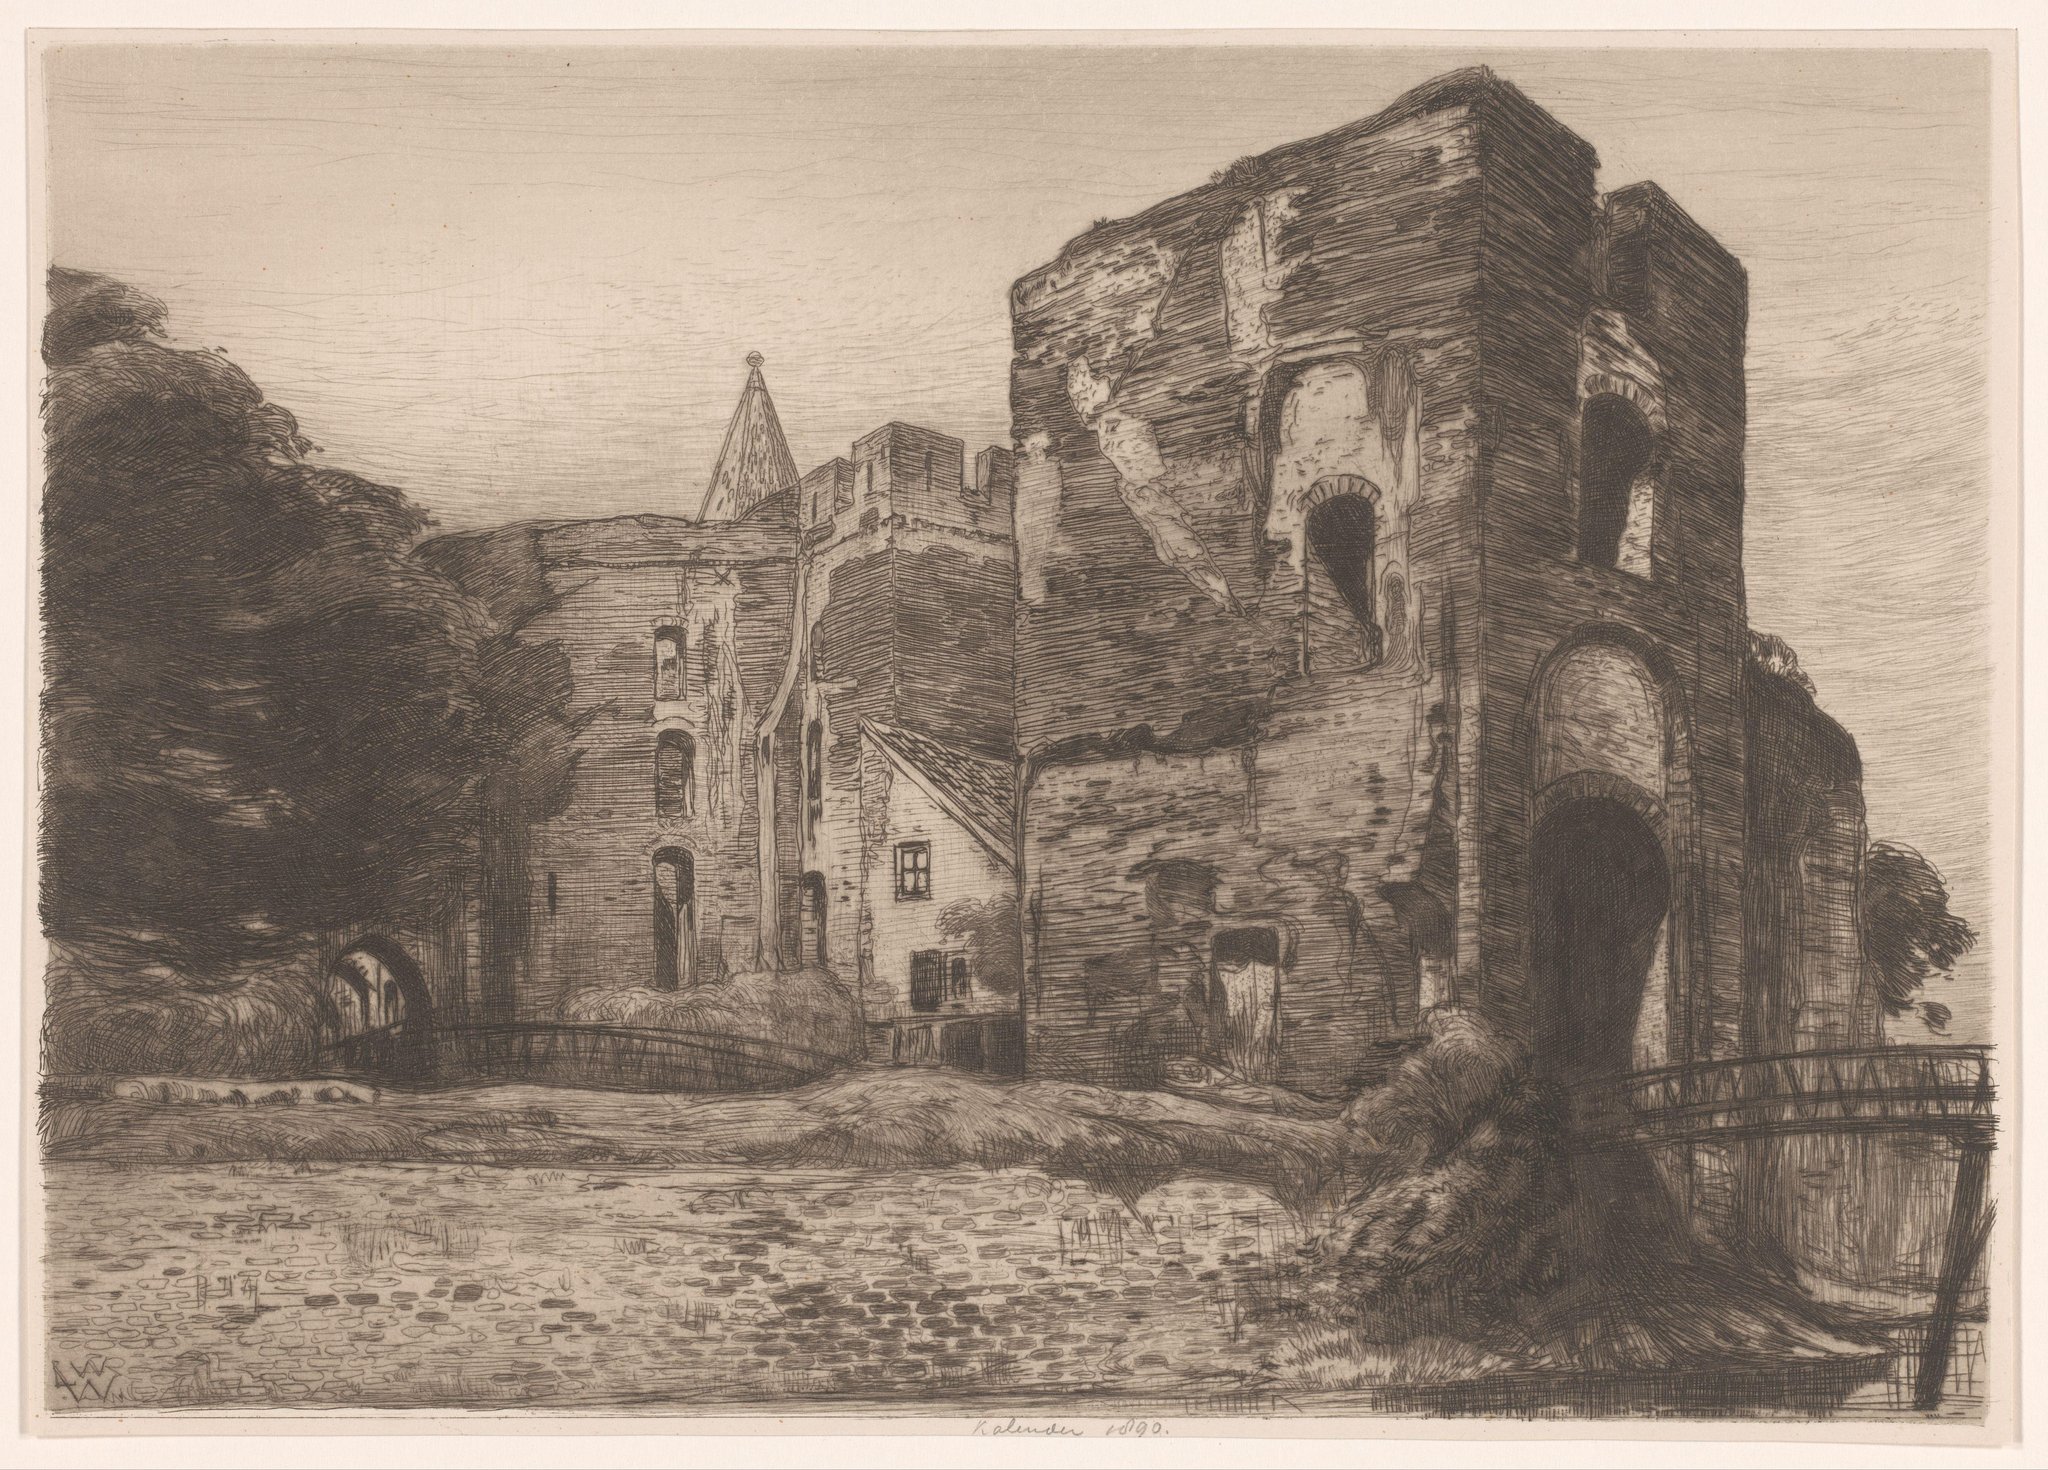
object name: print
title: Ruïne van Kasteel Brederode in Santpoort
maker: willem wenckebach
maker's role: designer, draughtsman, painter, print maker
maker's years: 1860-1937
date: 1890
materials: paper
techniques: drypoint, etching, intaglio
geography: netherlands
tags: castle, ruin of a building ~ architecture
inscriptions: inscription: ‘Brederode’, collector's mark: Lugt 2228, inscription: ‘Kalender 1890’